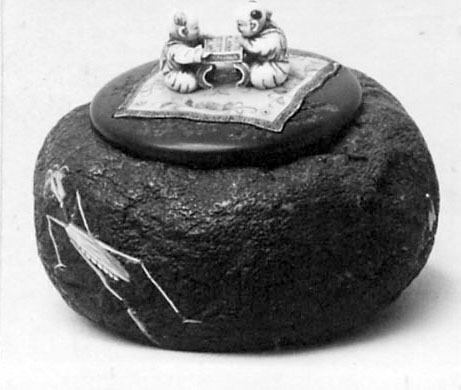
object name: box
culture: japanese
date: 1801-1900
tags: human figures